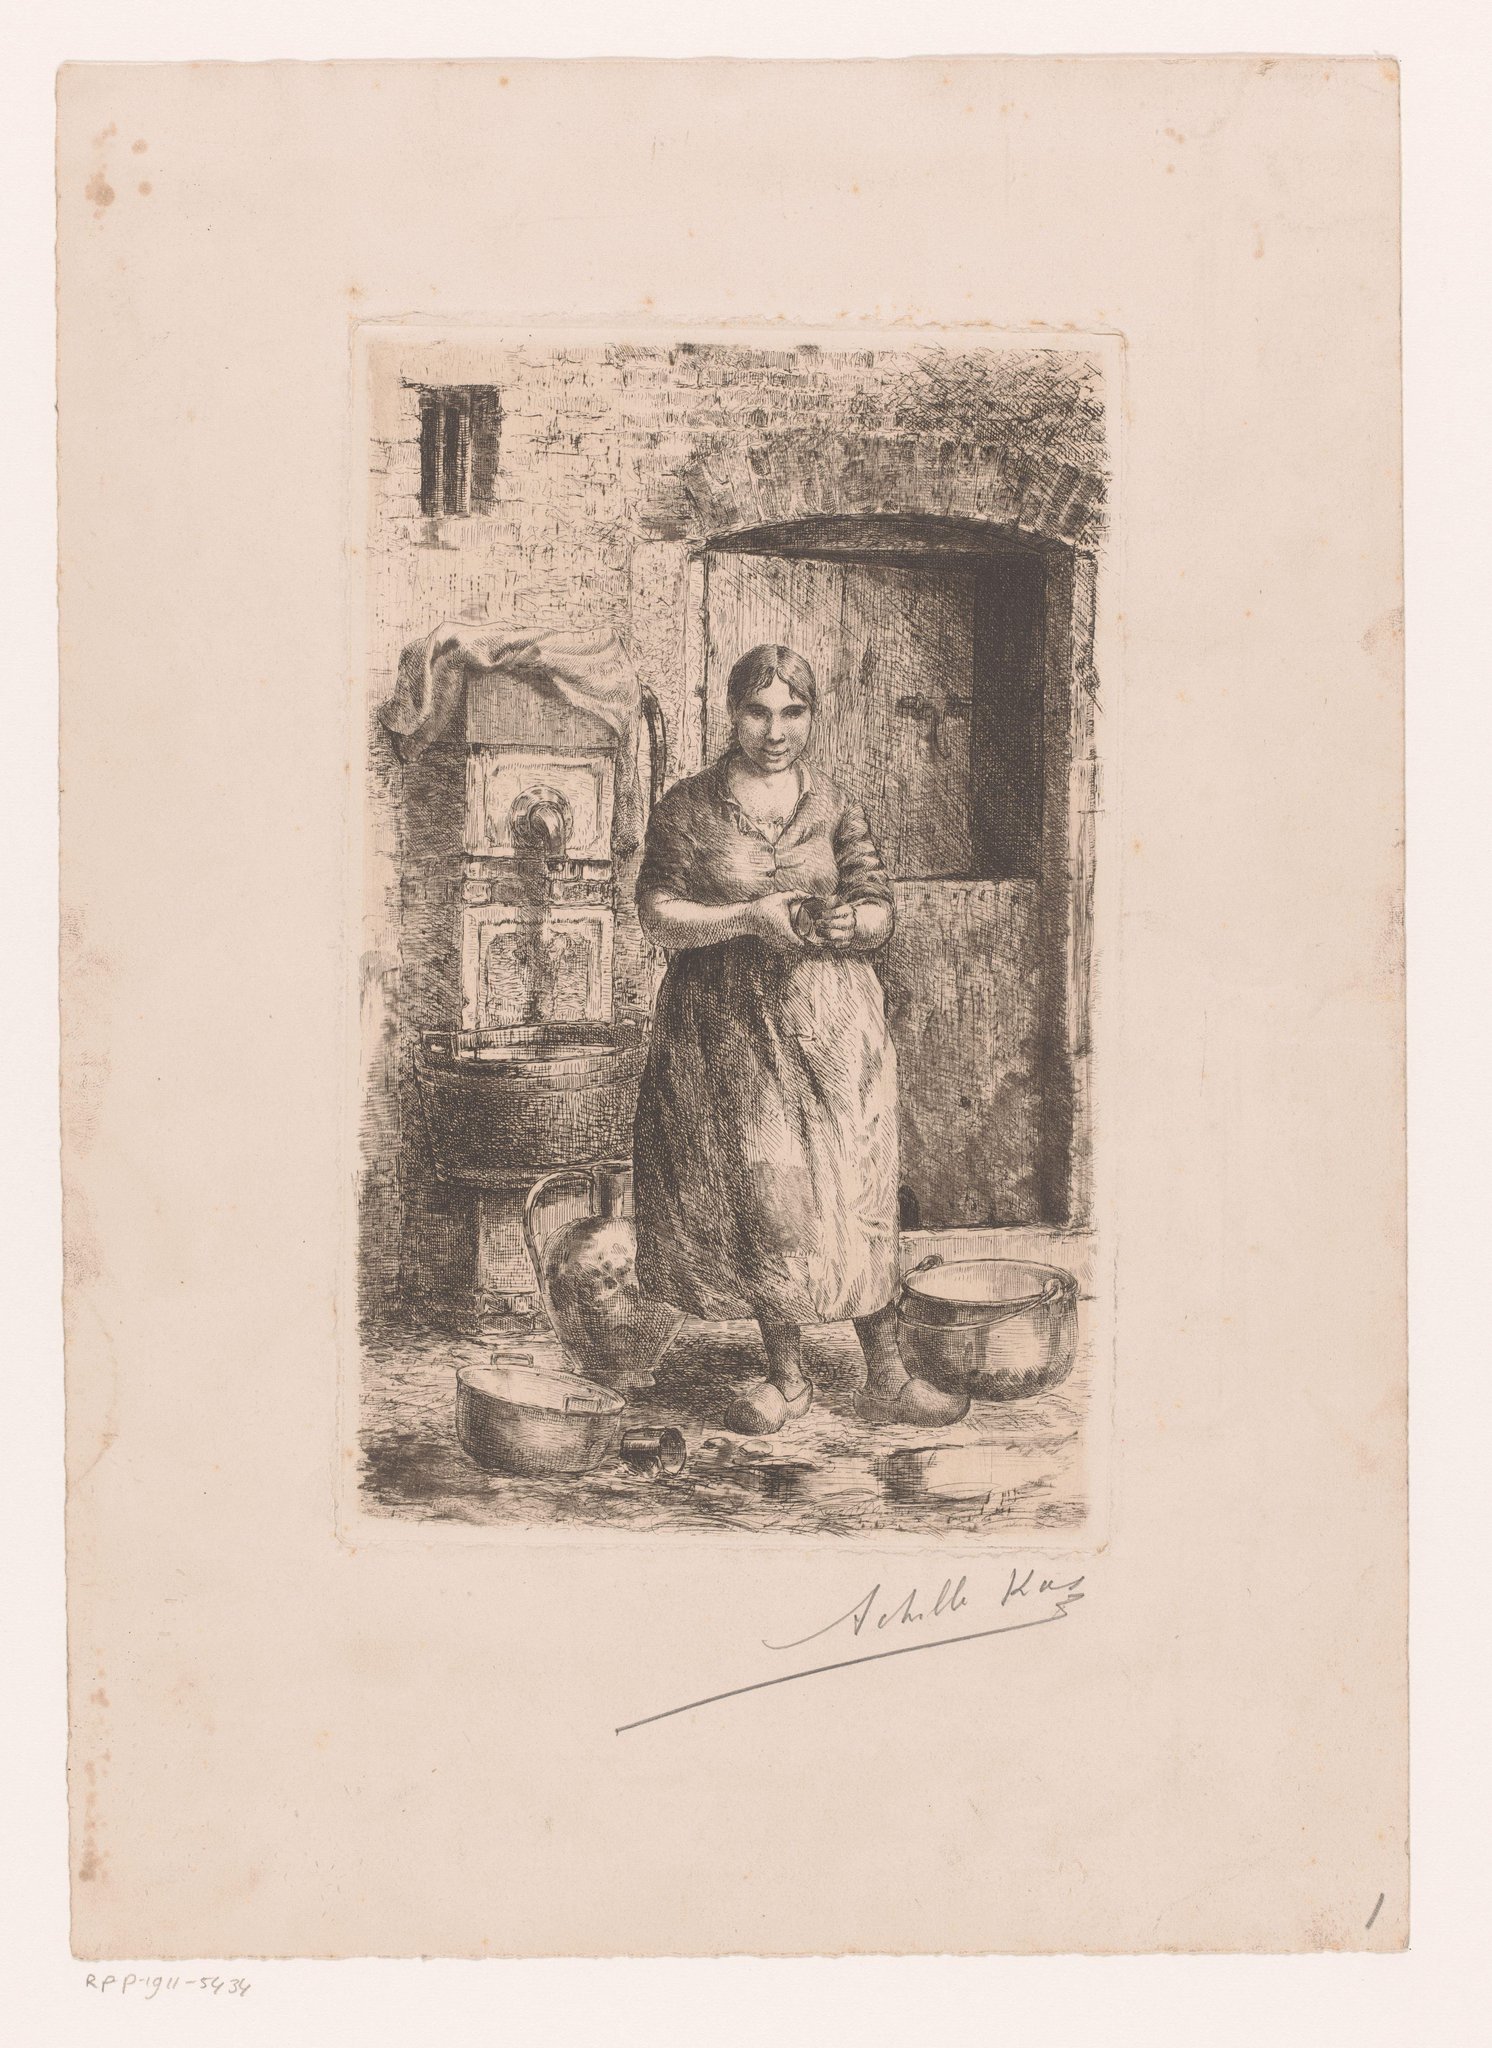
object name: print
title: Dienstbode staande bij een pomp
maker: achille kas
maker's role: print maker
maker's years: 1861-1927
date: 1871-1911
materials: paper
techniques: etching, intaglio, roulette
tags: adult woman, maid ~ house personnel, utilitarian, public pump or water fountain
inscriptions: collector's mark: Lugt 2228